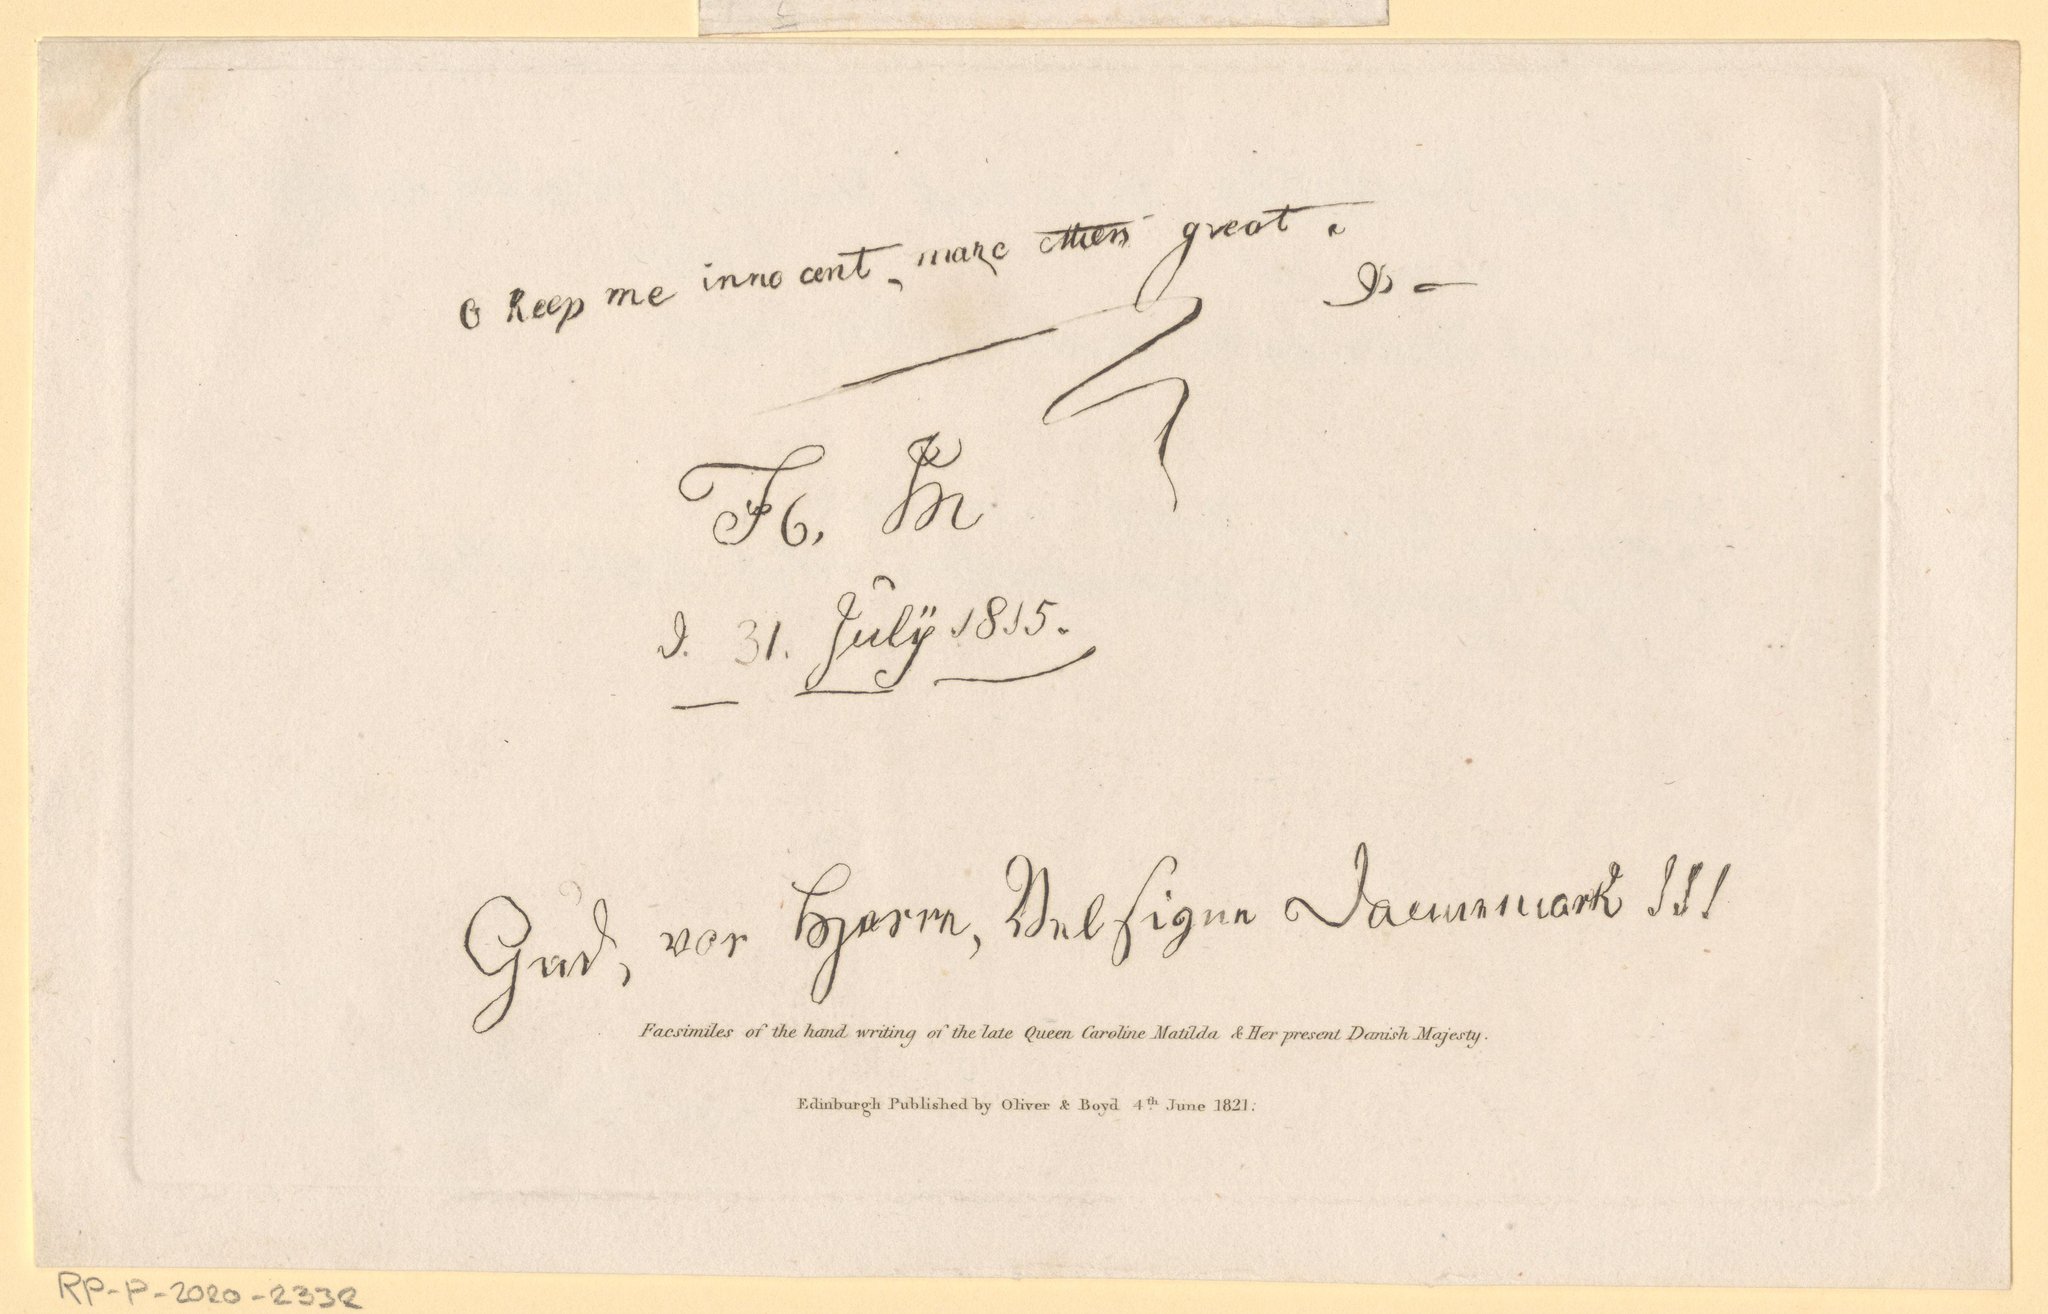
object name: print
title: Facsimile van het handschrift van Caroline Mathilde, prinses van Wales en koningin van Denemarken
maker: Anonymous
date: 1821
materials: paper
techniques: engraving, etching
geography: edinburgh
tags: london, historical persons, queen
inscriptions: date